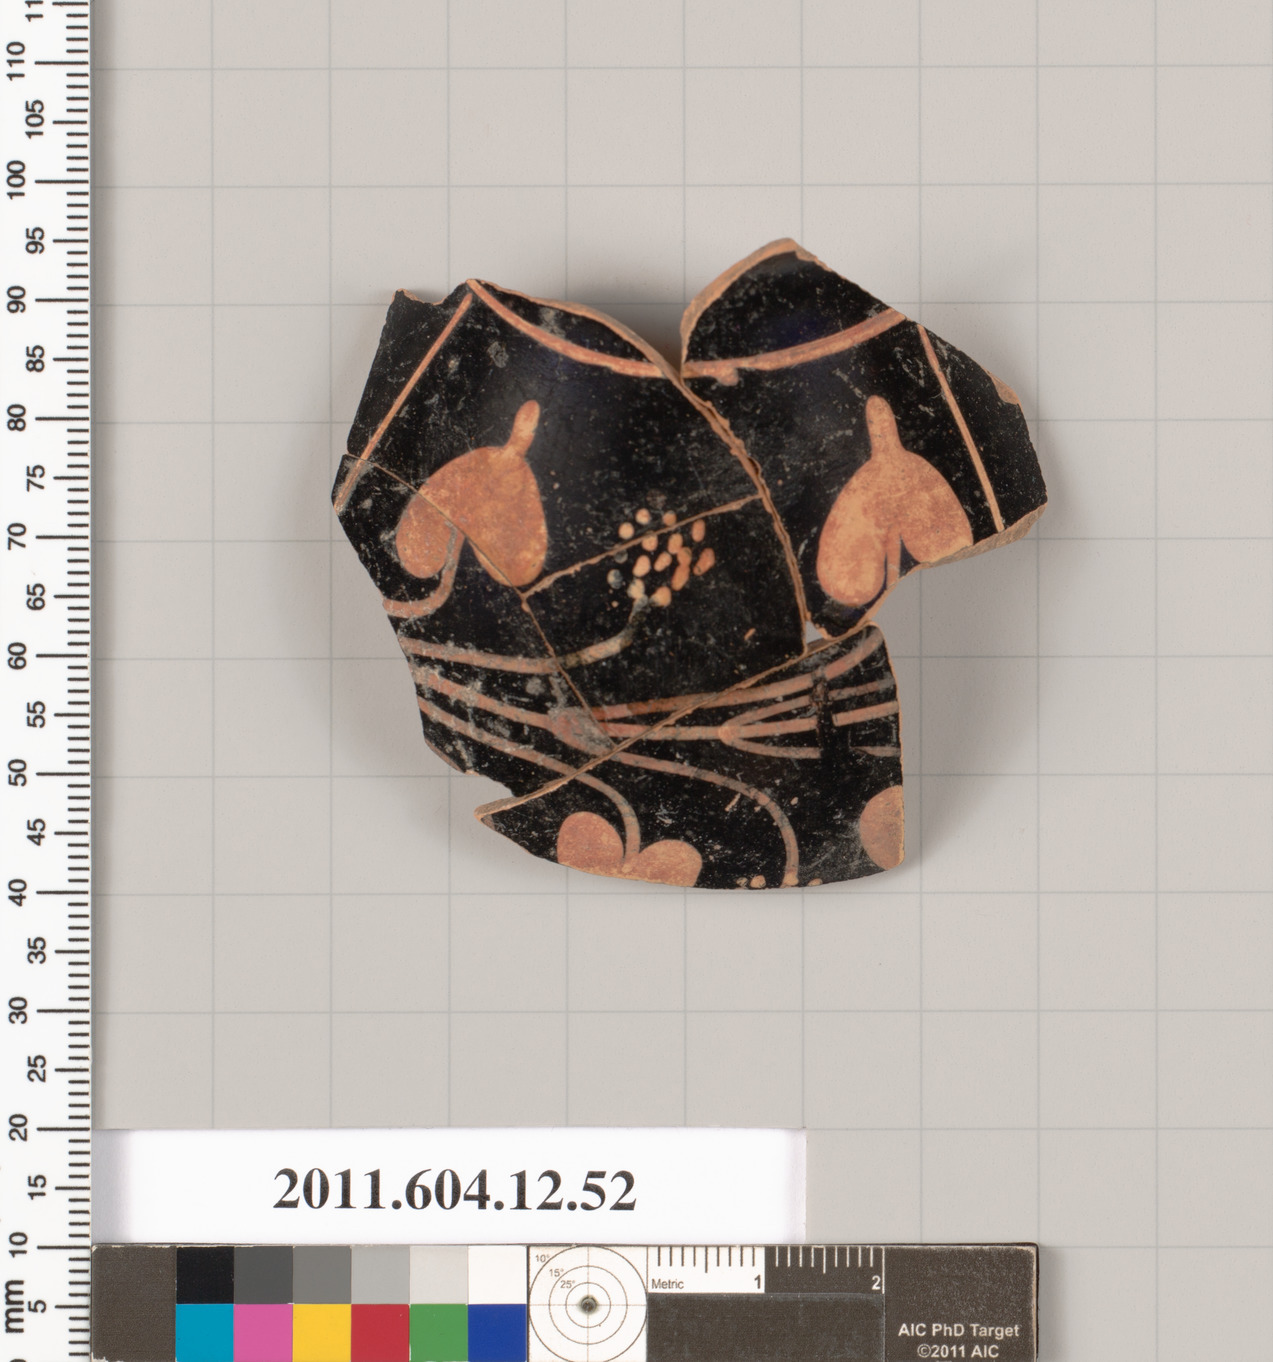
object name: chou fragment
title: Terracotta fragment of a chous (jug)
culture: greek or south italian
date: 400-301 BCE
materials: terracotta